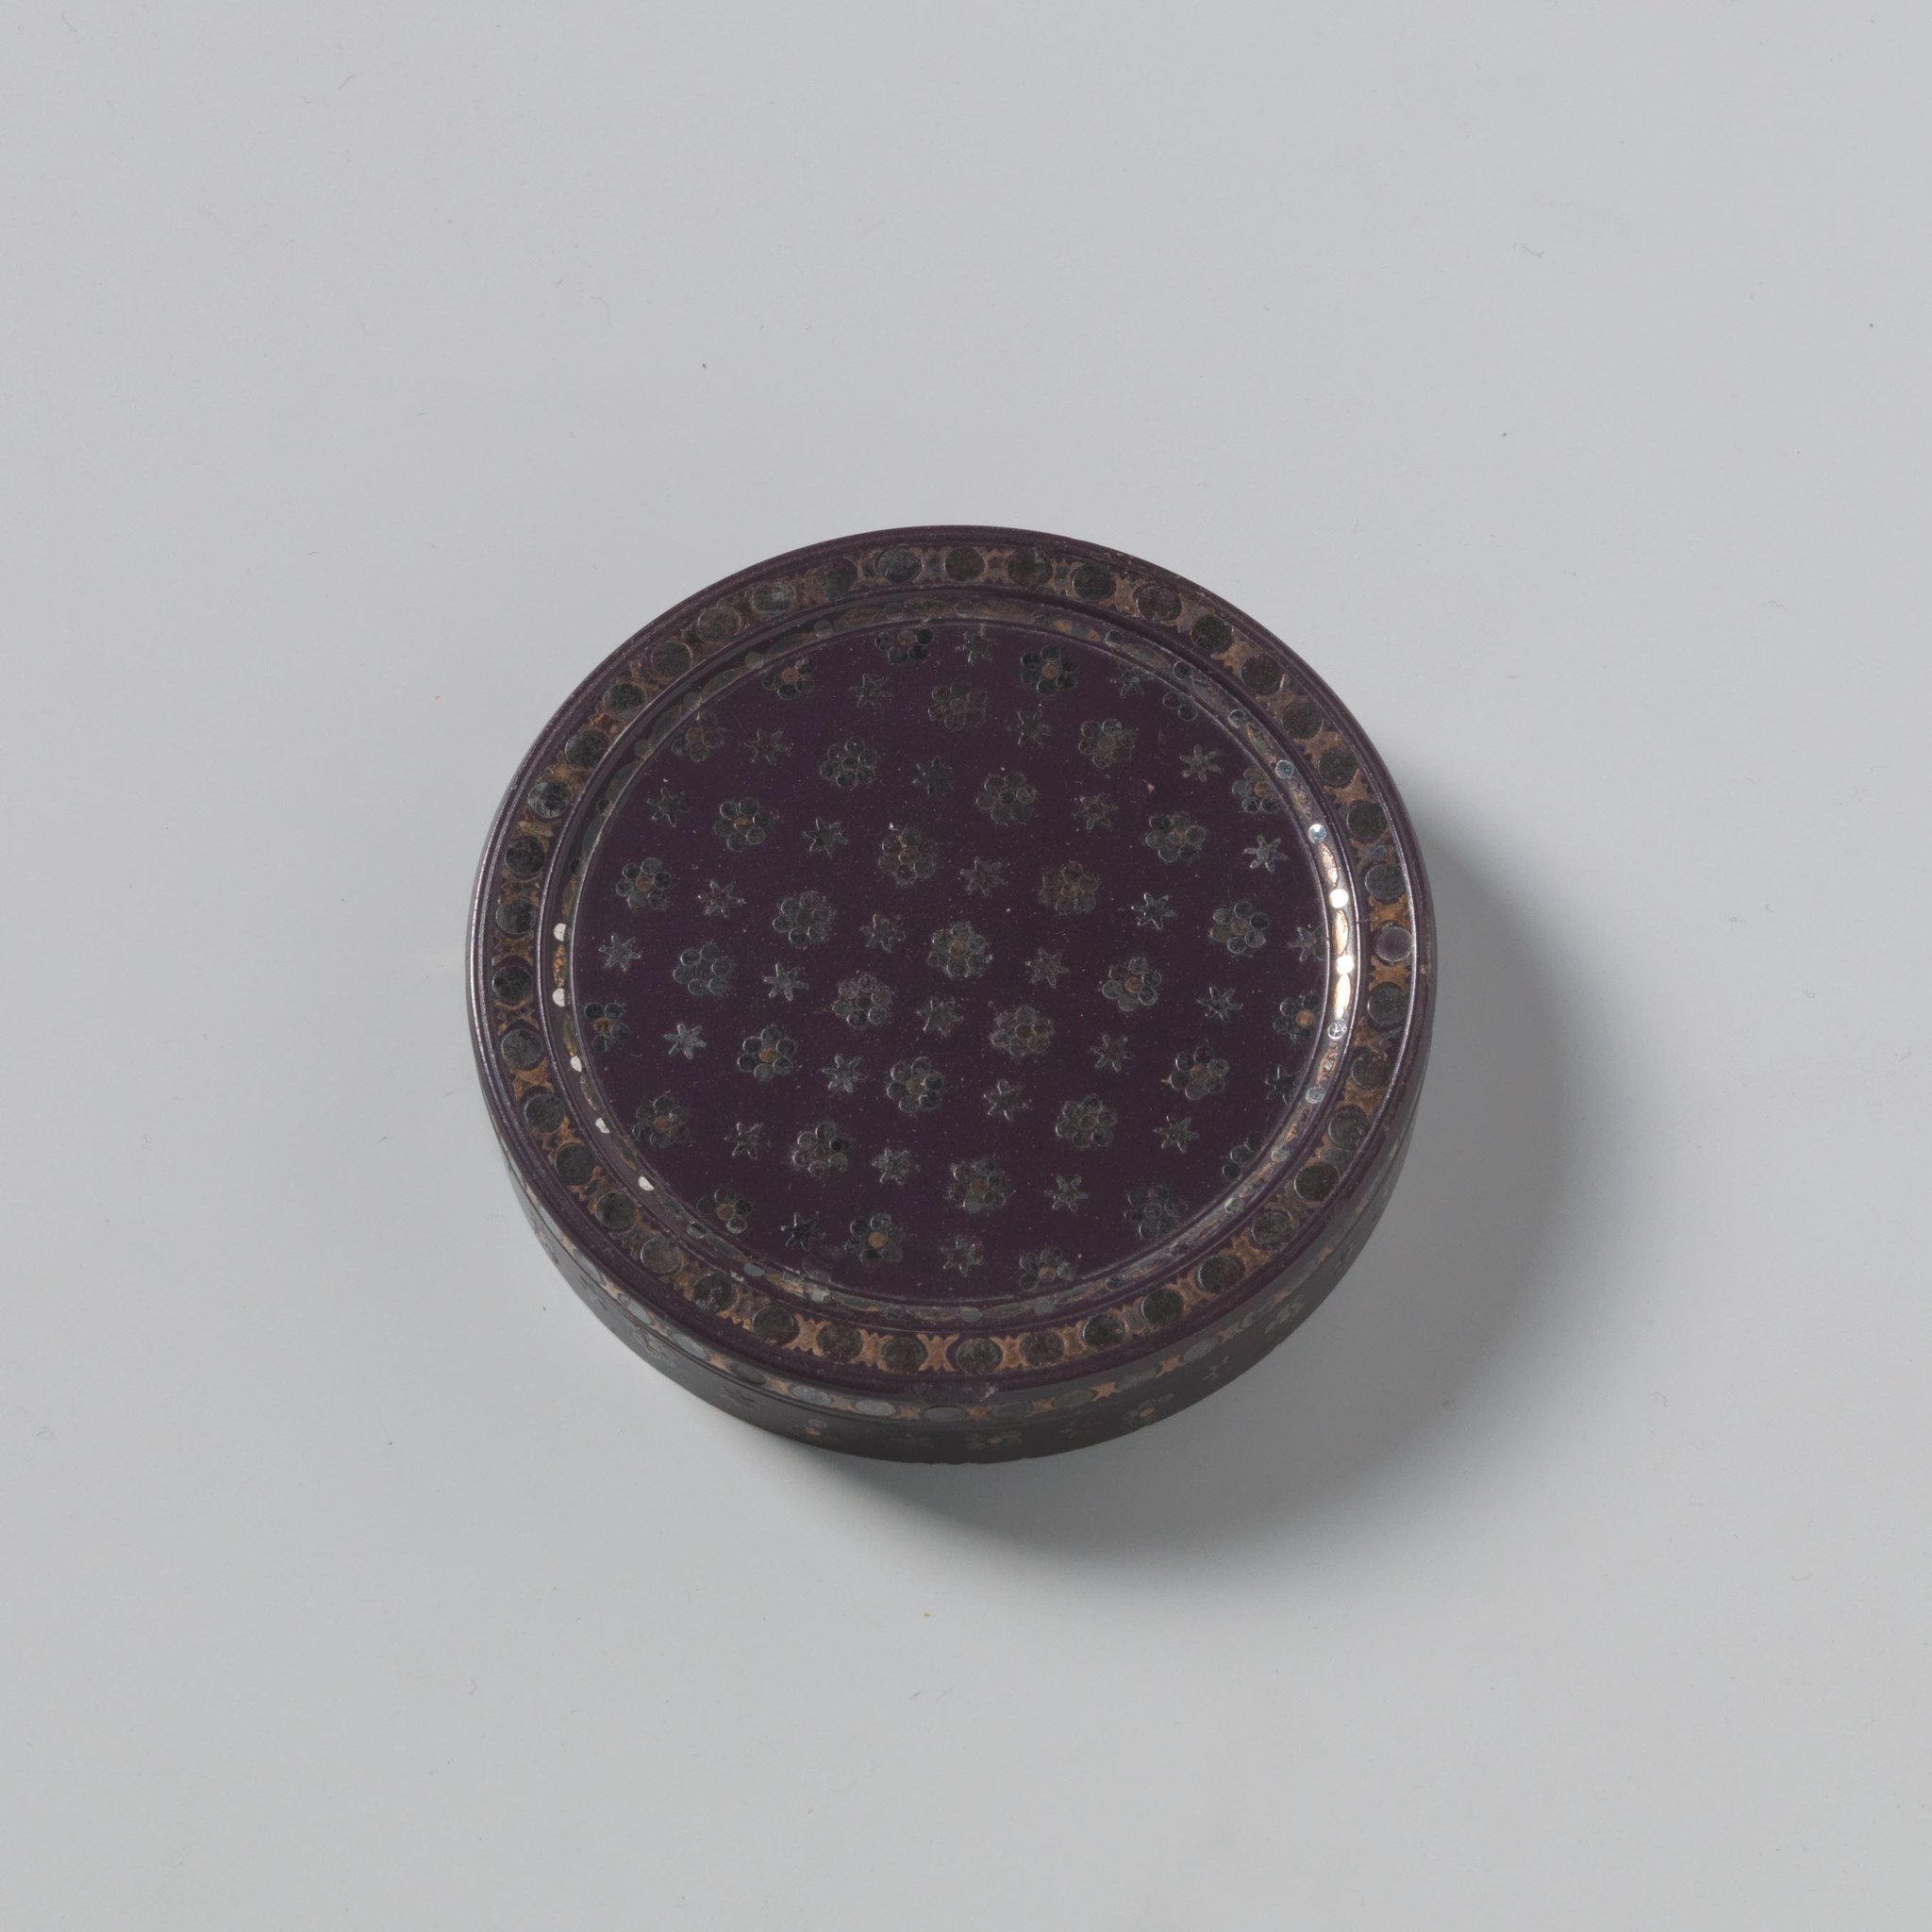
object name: box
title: Onderste gedeelte van een lakwerkdoos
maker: Anonymous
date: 1762-1818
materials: brass, metal, silver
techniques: lacquer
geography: netherlands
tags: herman willem daendels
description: Onderste gedeelte van een rond lakwerkdoosje. Met deksel (NG-2000-2-E-2).